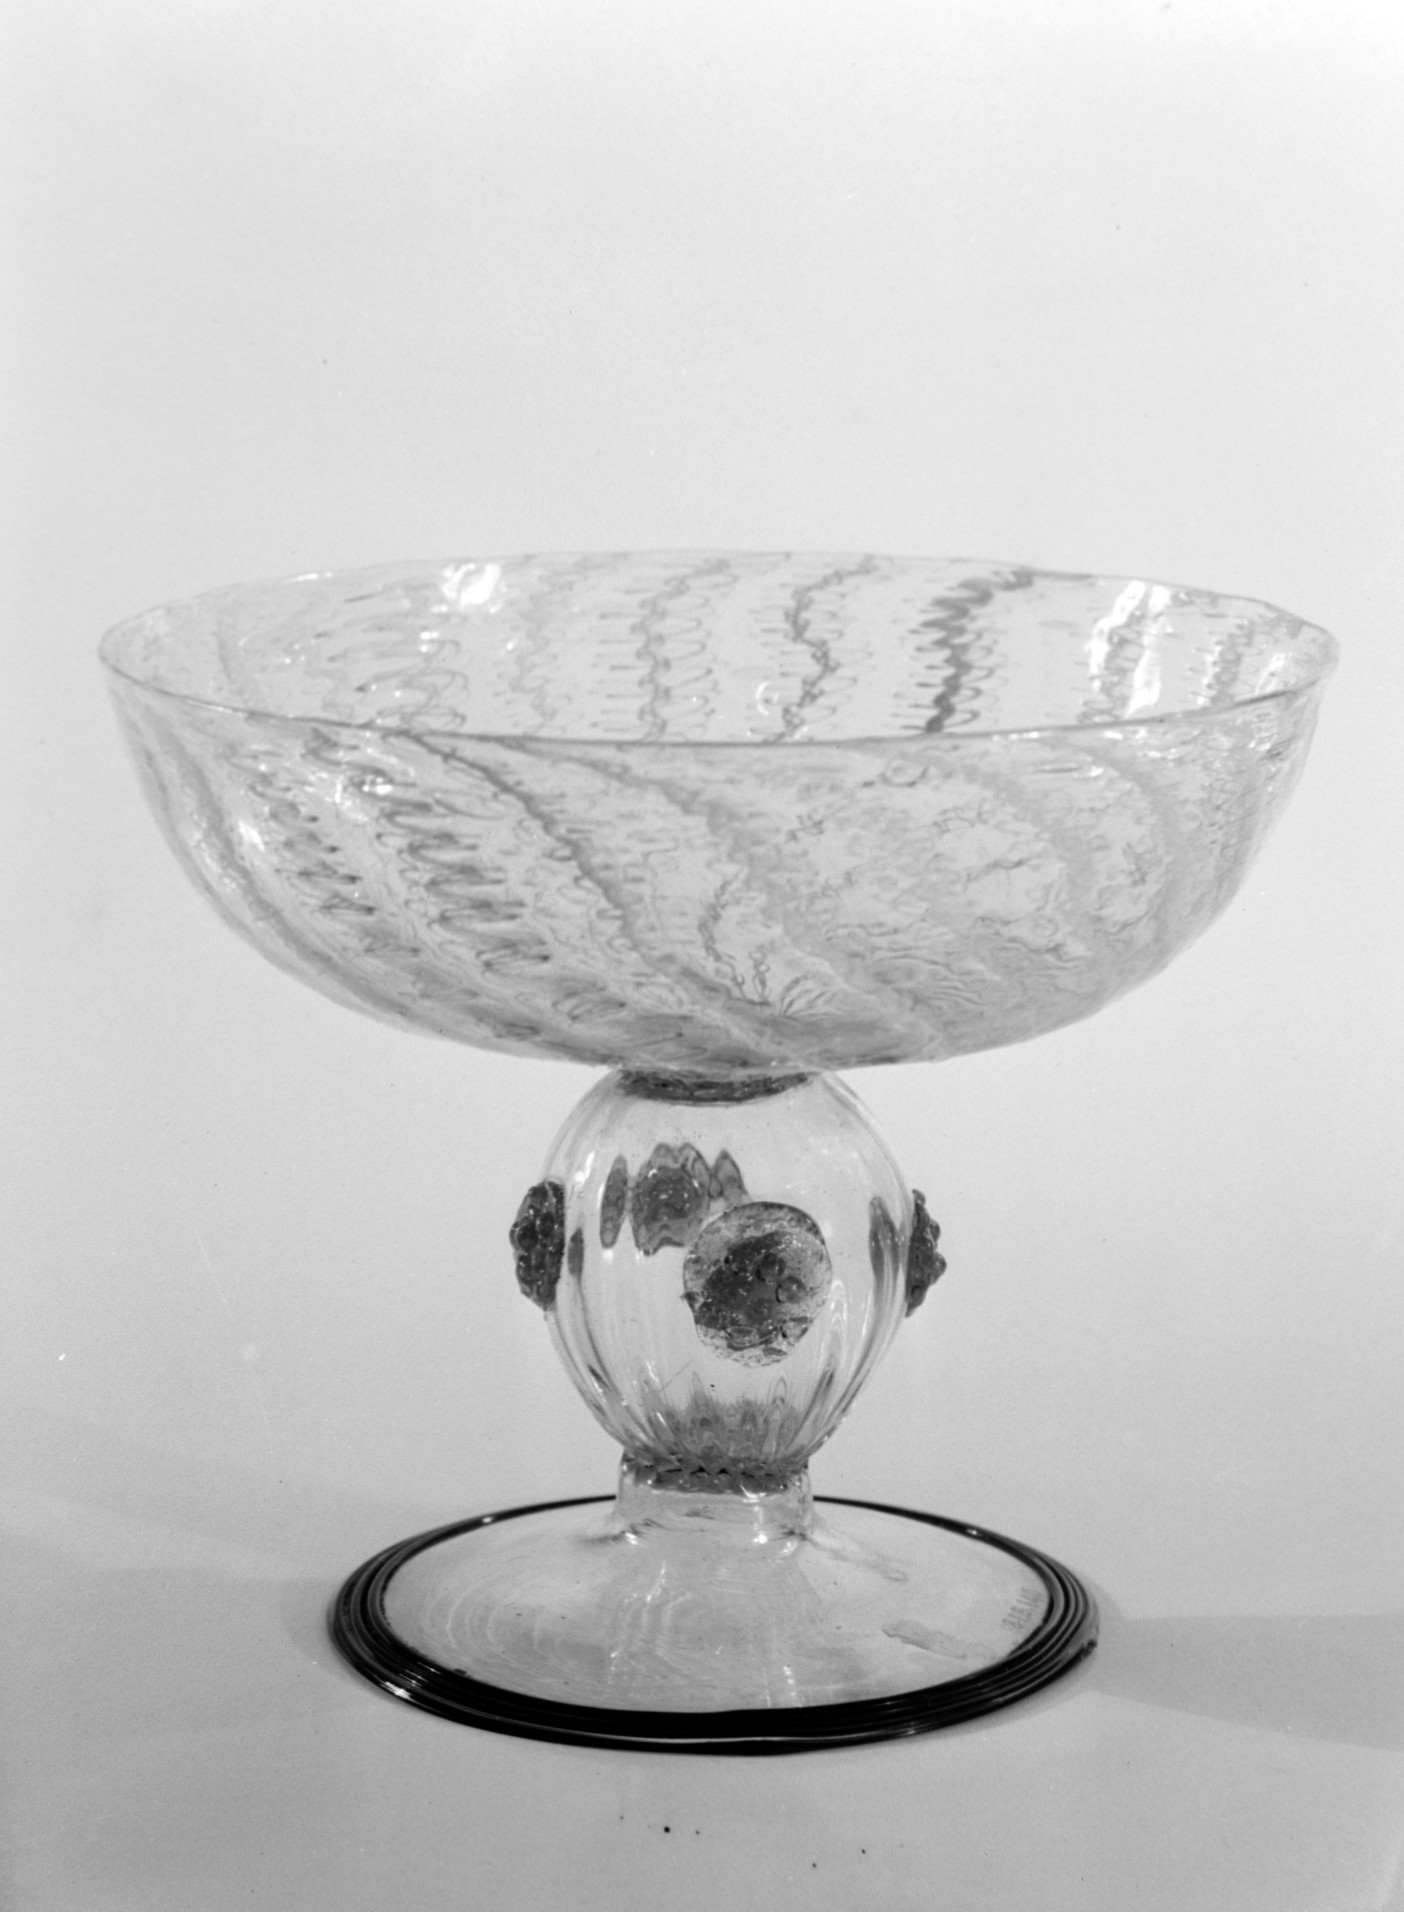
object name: tazza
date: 1601-1700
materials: glass